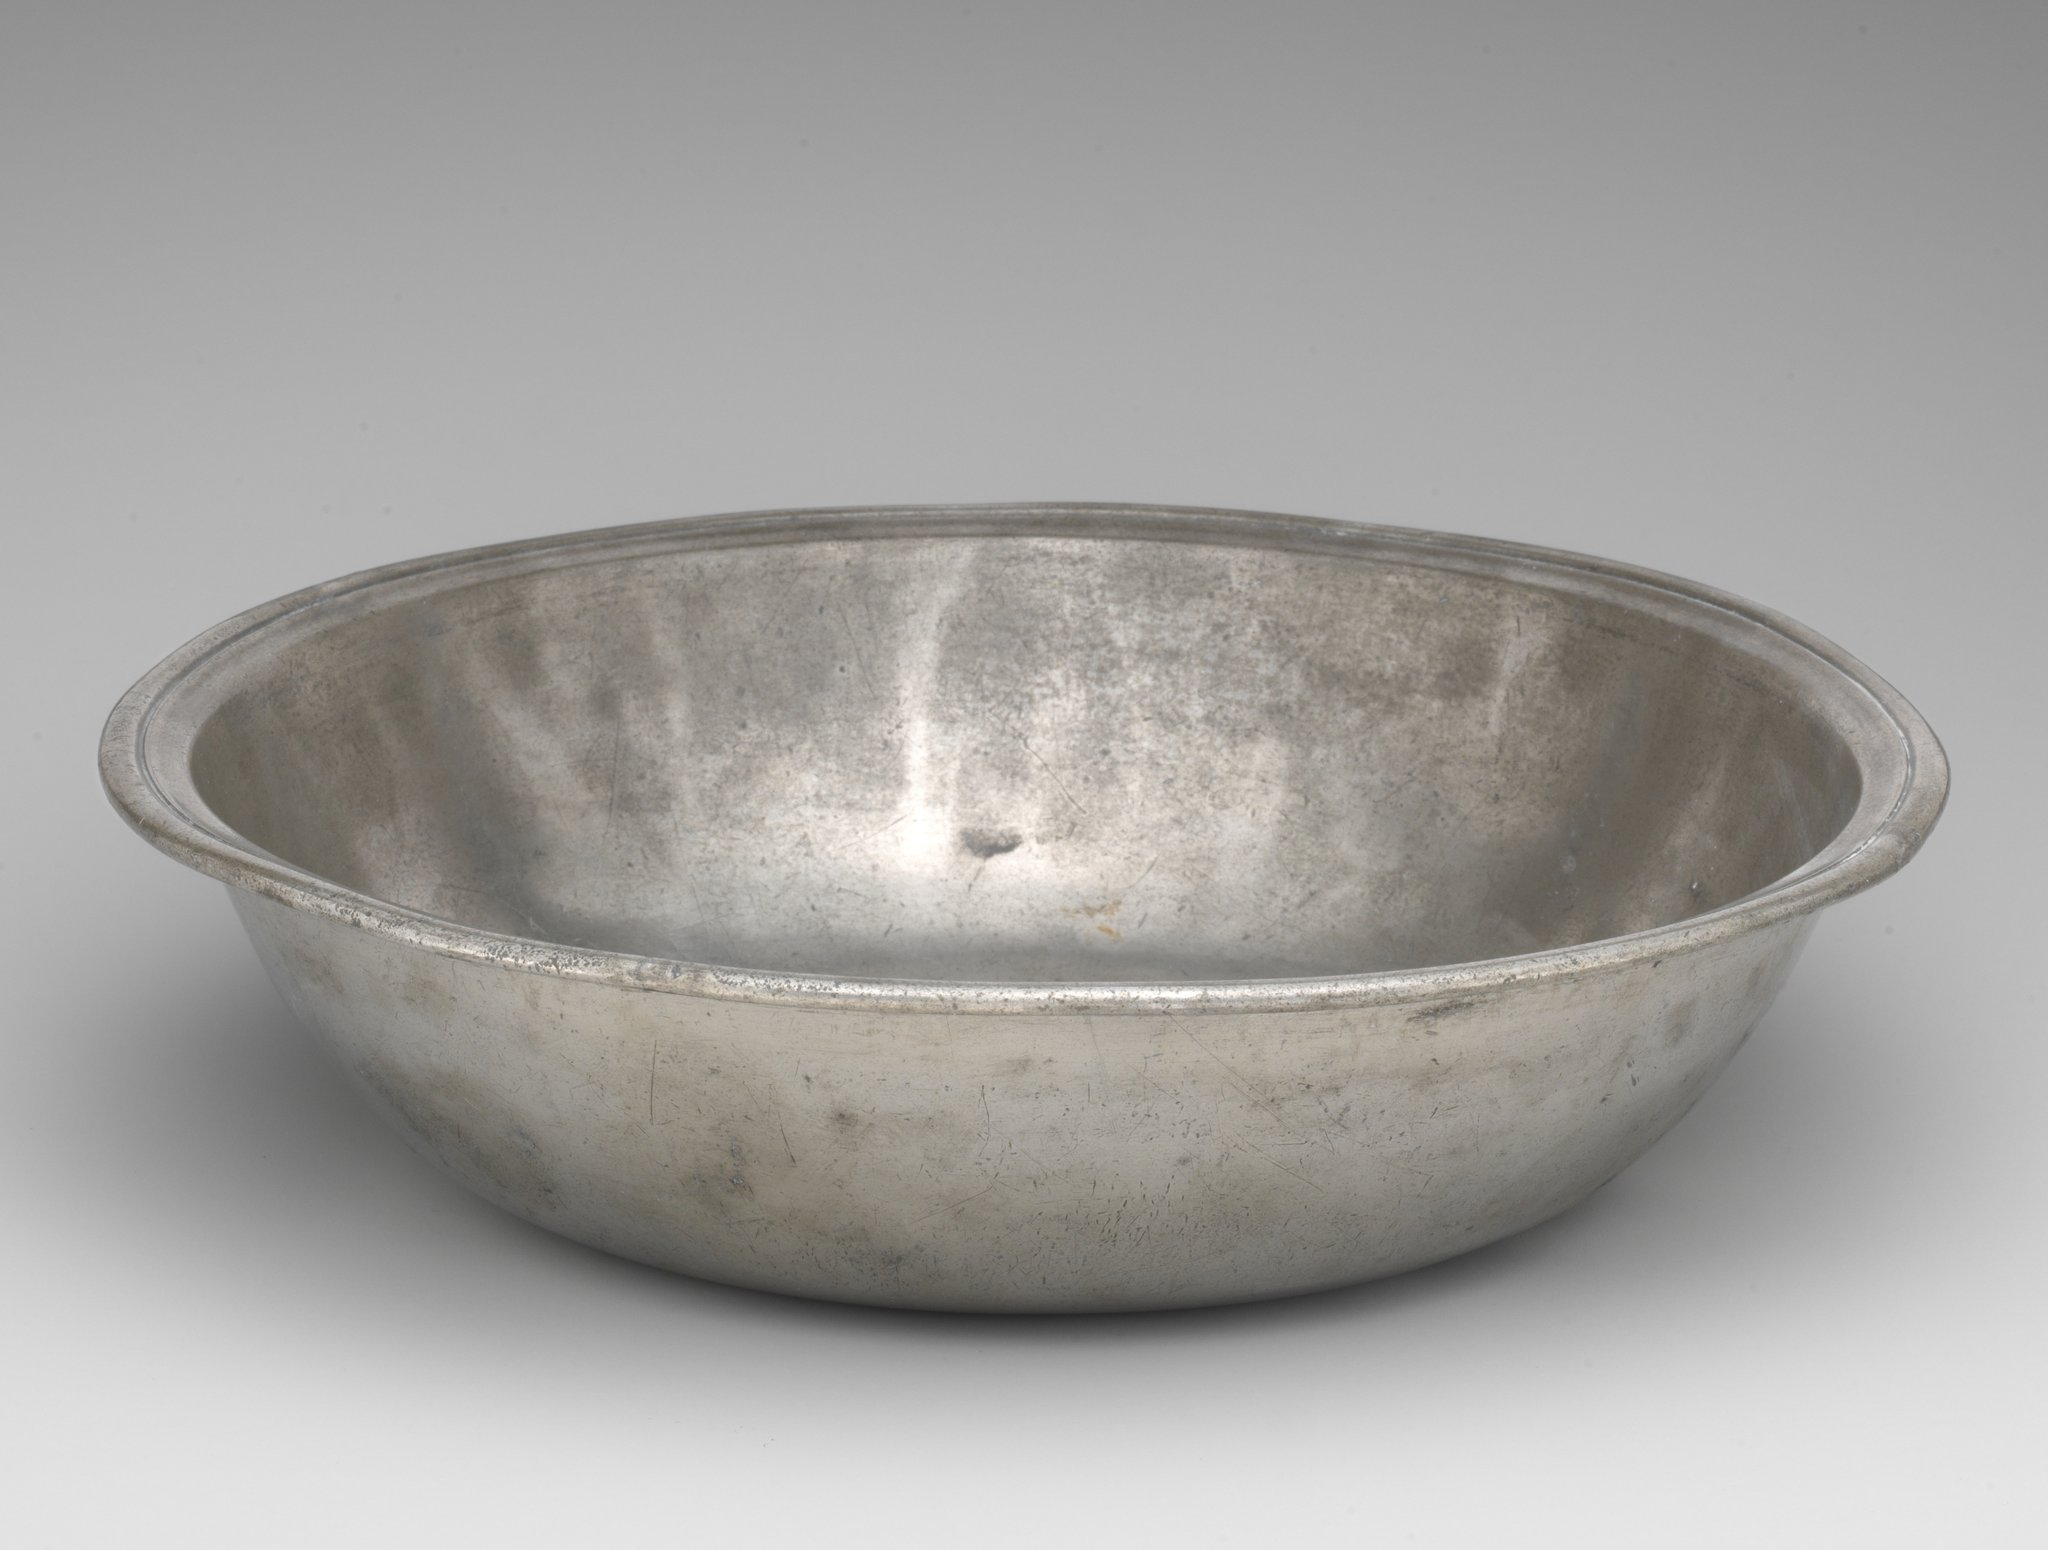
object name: bowl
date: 1701-1800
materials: pewter